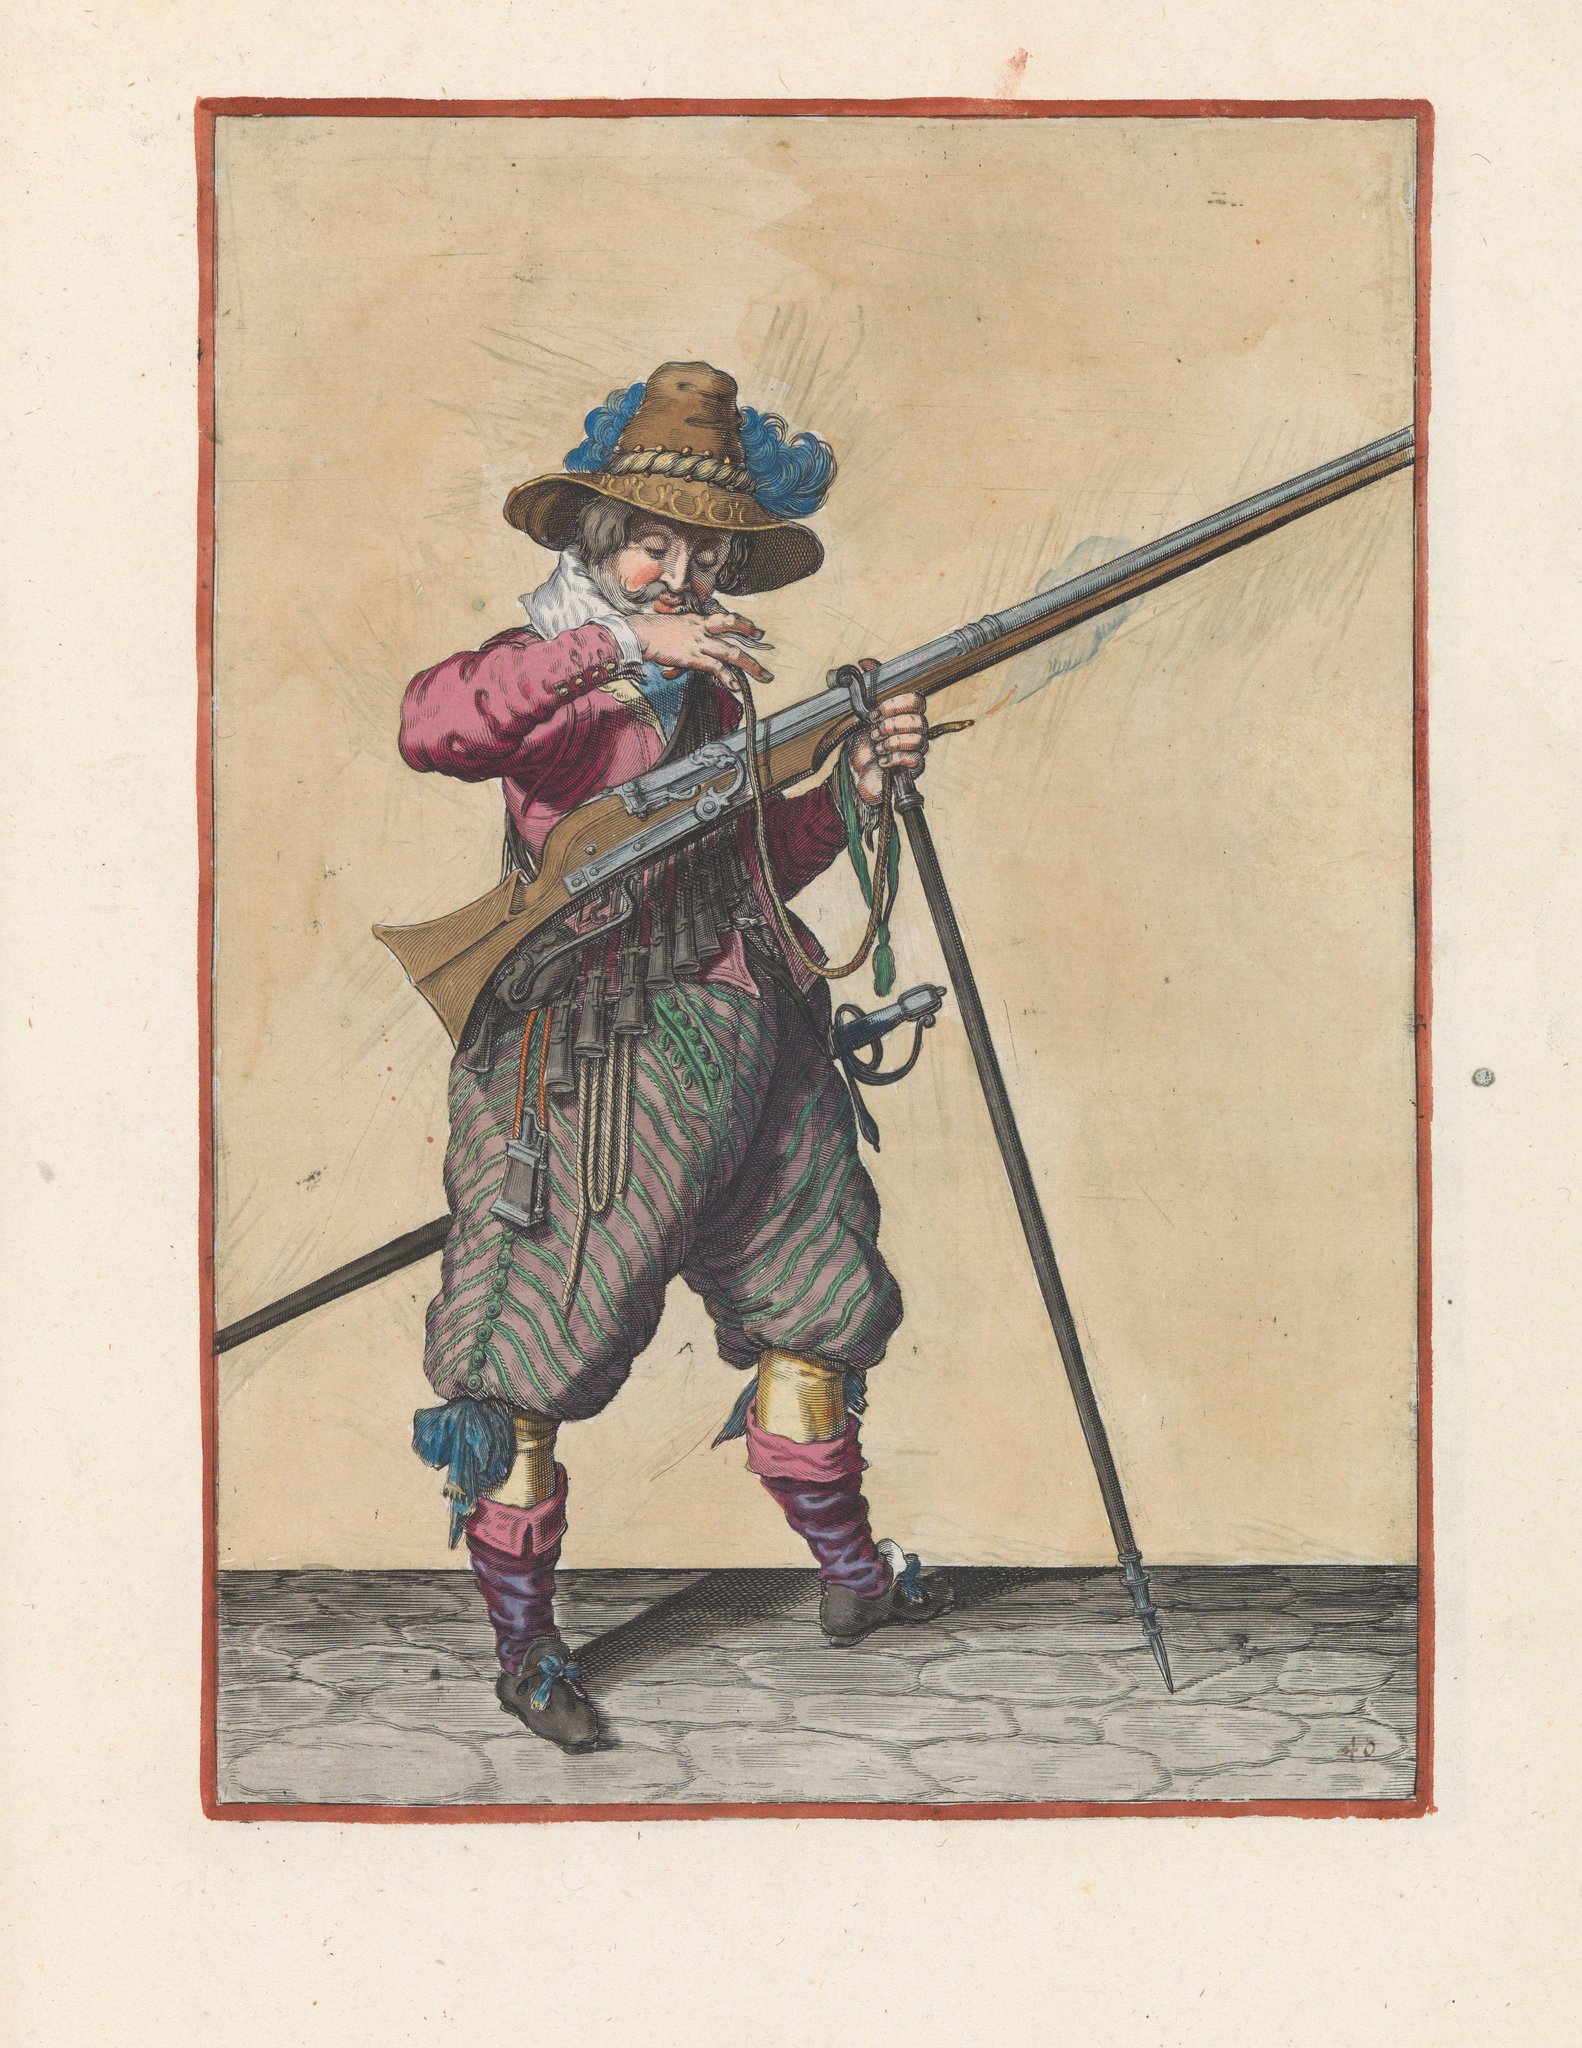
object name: print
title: Corte onderrechtinghe op de figuerliicke afbeeldinghe, soo veel aengaet het recht ghebruyck vant Musquet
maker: jacques de gheyn (ii)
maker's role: painter, print maker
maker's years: 1565-1629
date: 1597-1607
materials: paper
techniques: engraving, hand coloring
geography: the hague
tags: handling of weapons ~ military training, firearms: rifle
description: Een soldaat op wacht, ten voeten uit, naar rechts, die een musket (een bepaald type vuurwapen) met zijn linkerhand vasthoudt bij de vork van het furket (musketvork) waar de loop op steunt. Met zijn rechterhand brengt hij een brandende lont naar zijn mond om hem schoon te blazen. Deze prent is onderdeel van de reeks van 43 met de hand genummerde prenten van musketiers in de Wapenhandelinghe.